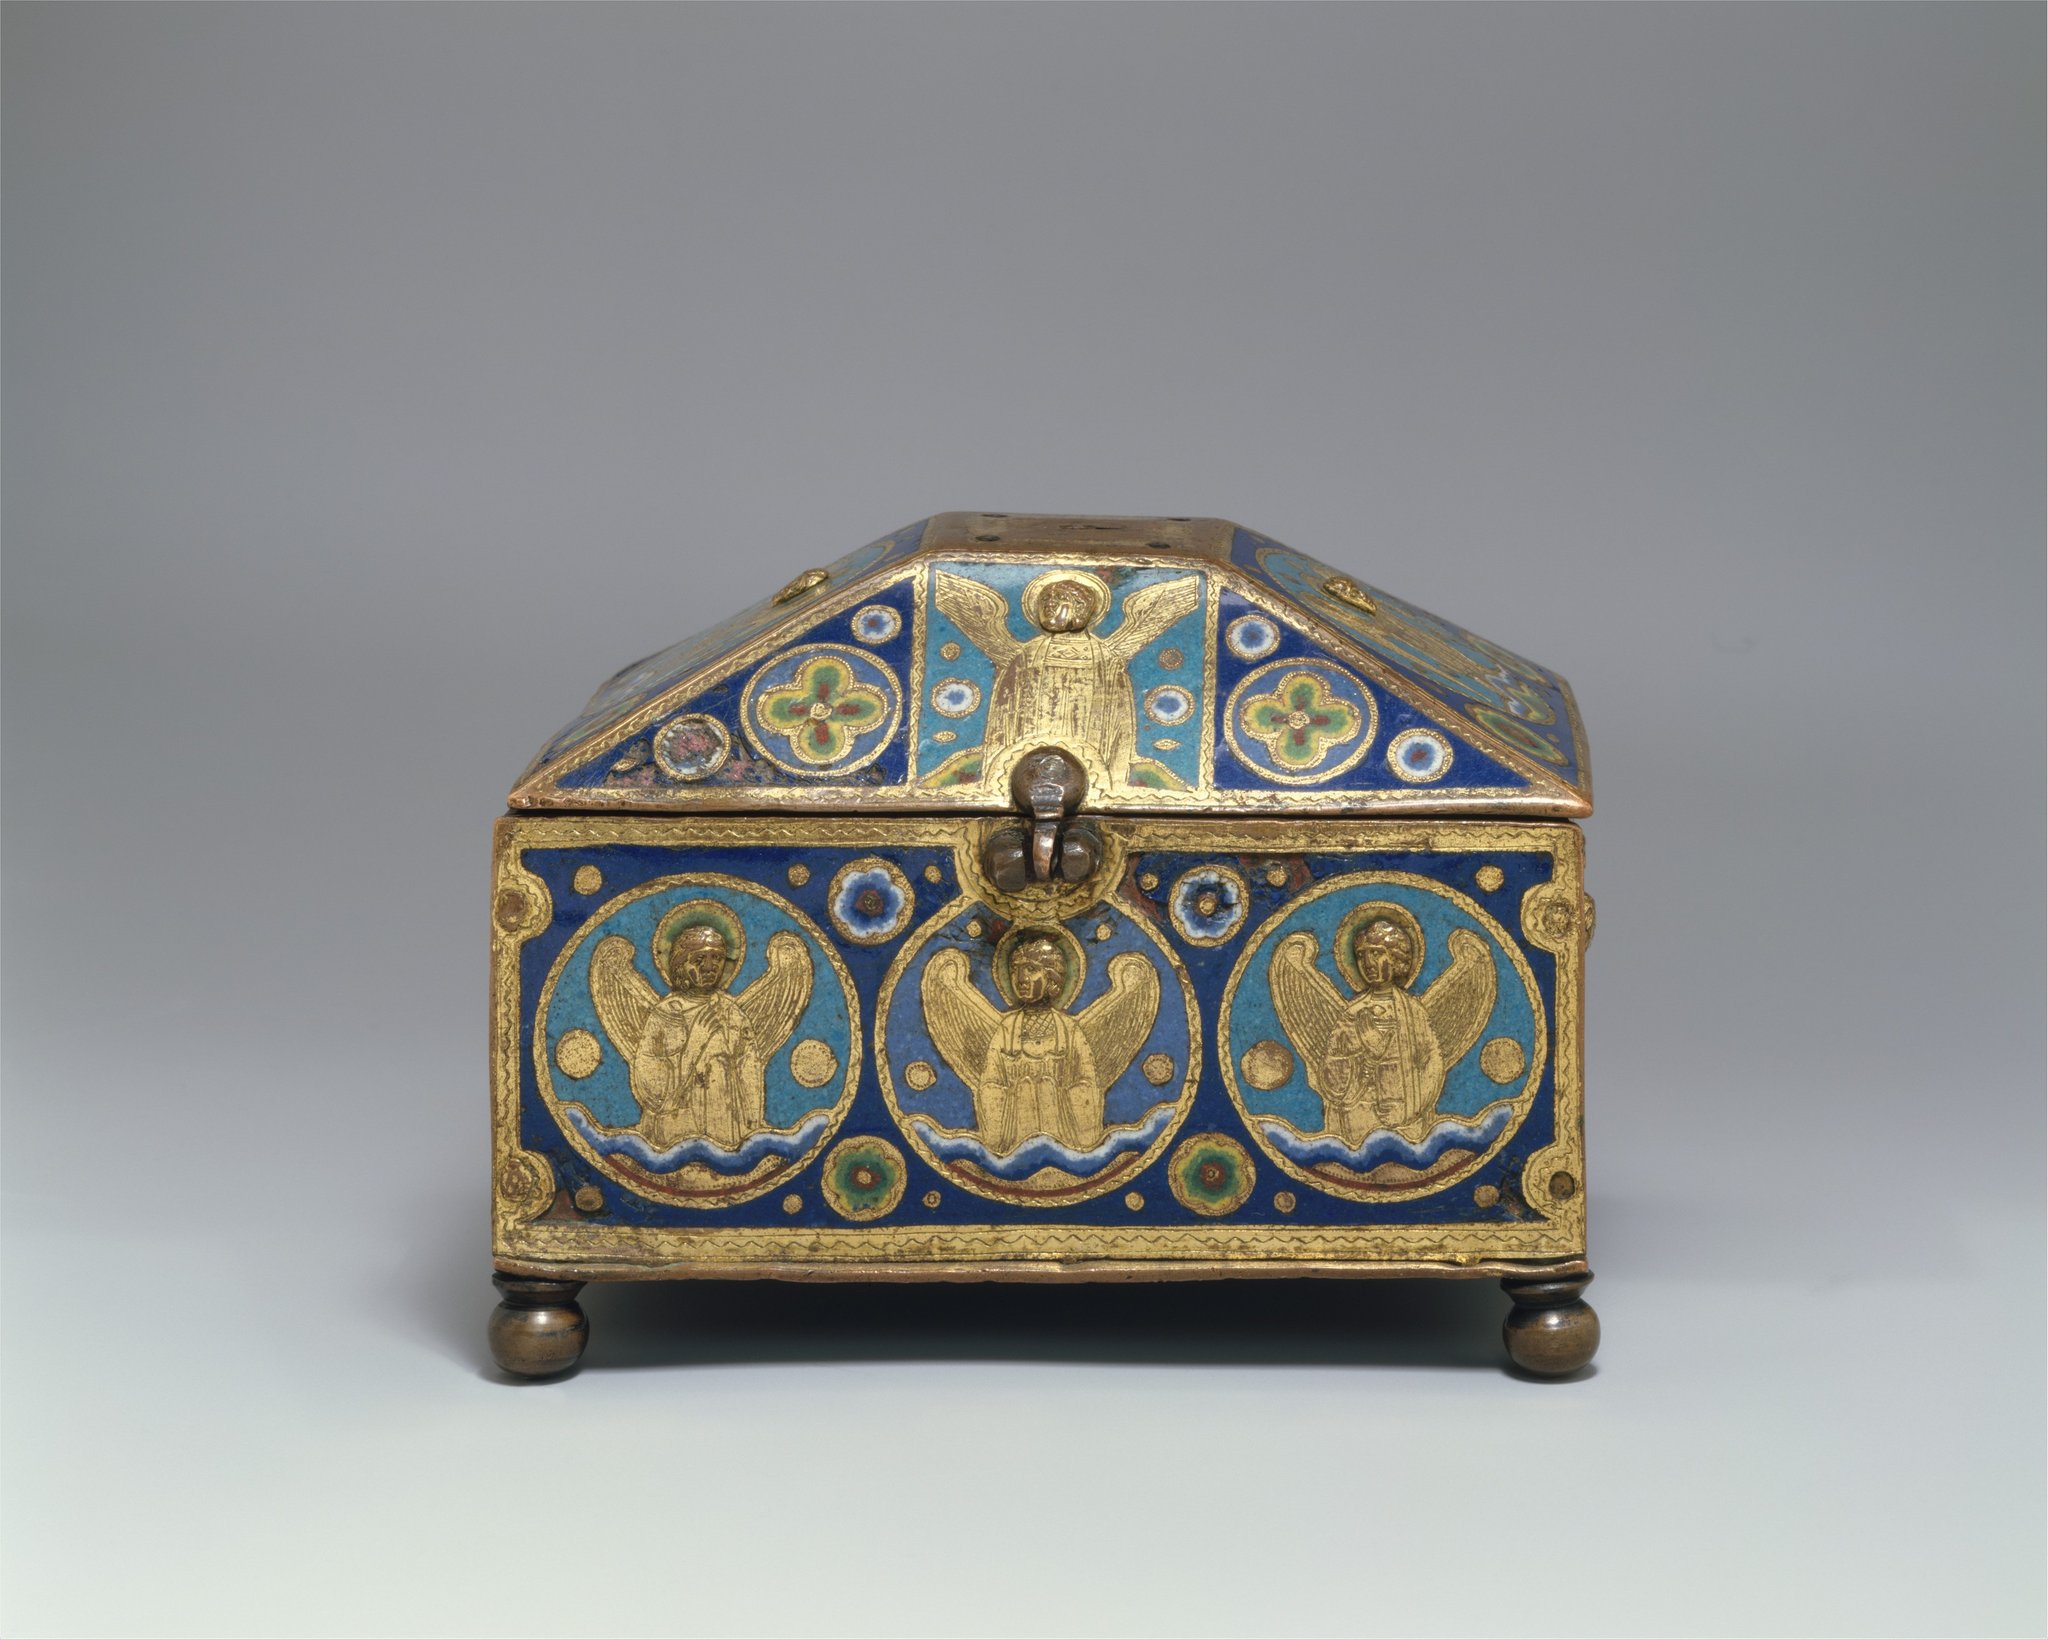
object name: chrismatory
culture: french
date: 1200-1220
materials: copper, enamel, gilt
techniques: enamel, chasing, engraving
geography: france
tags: angels